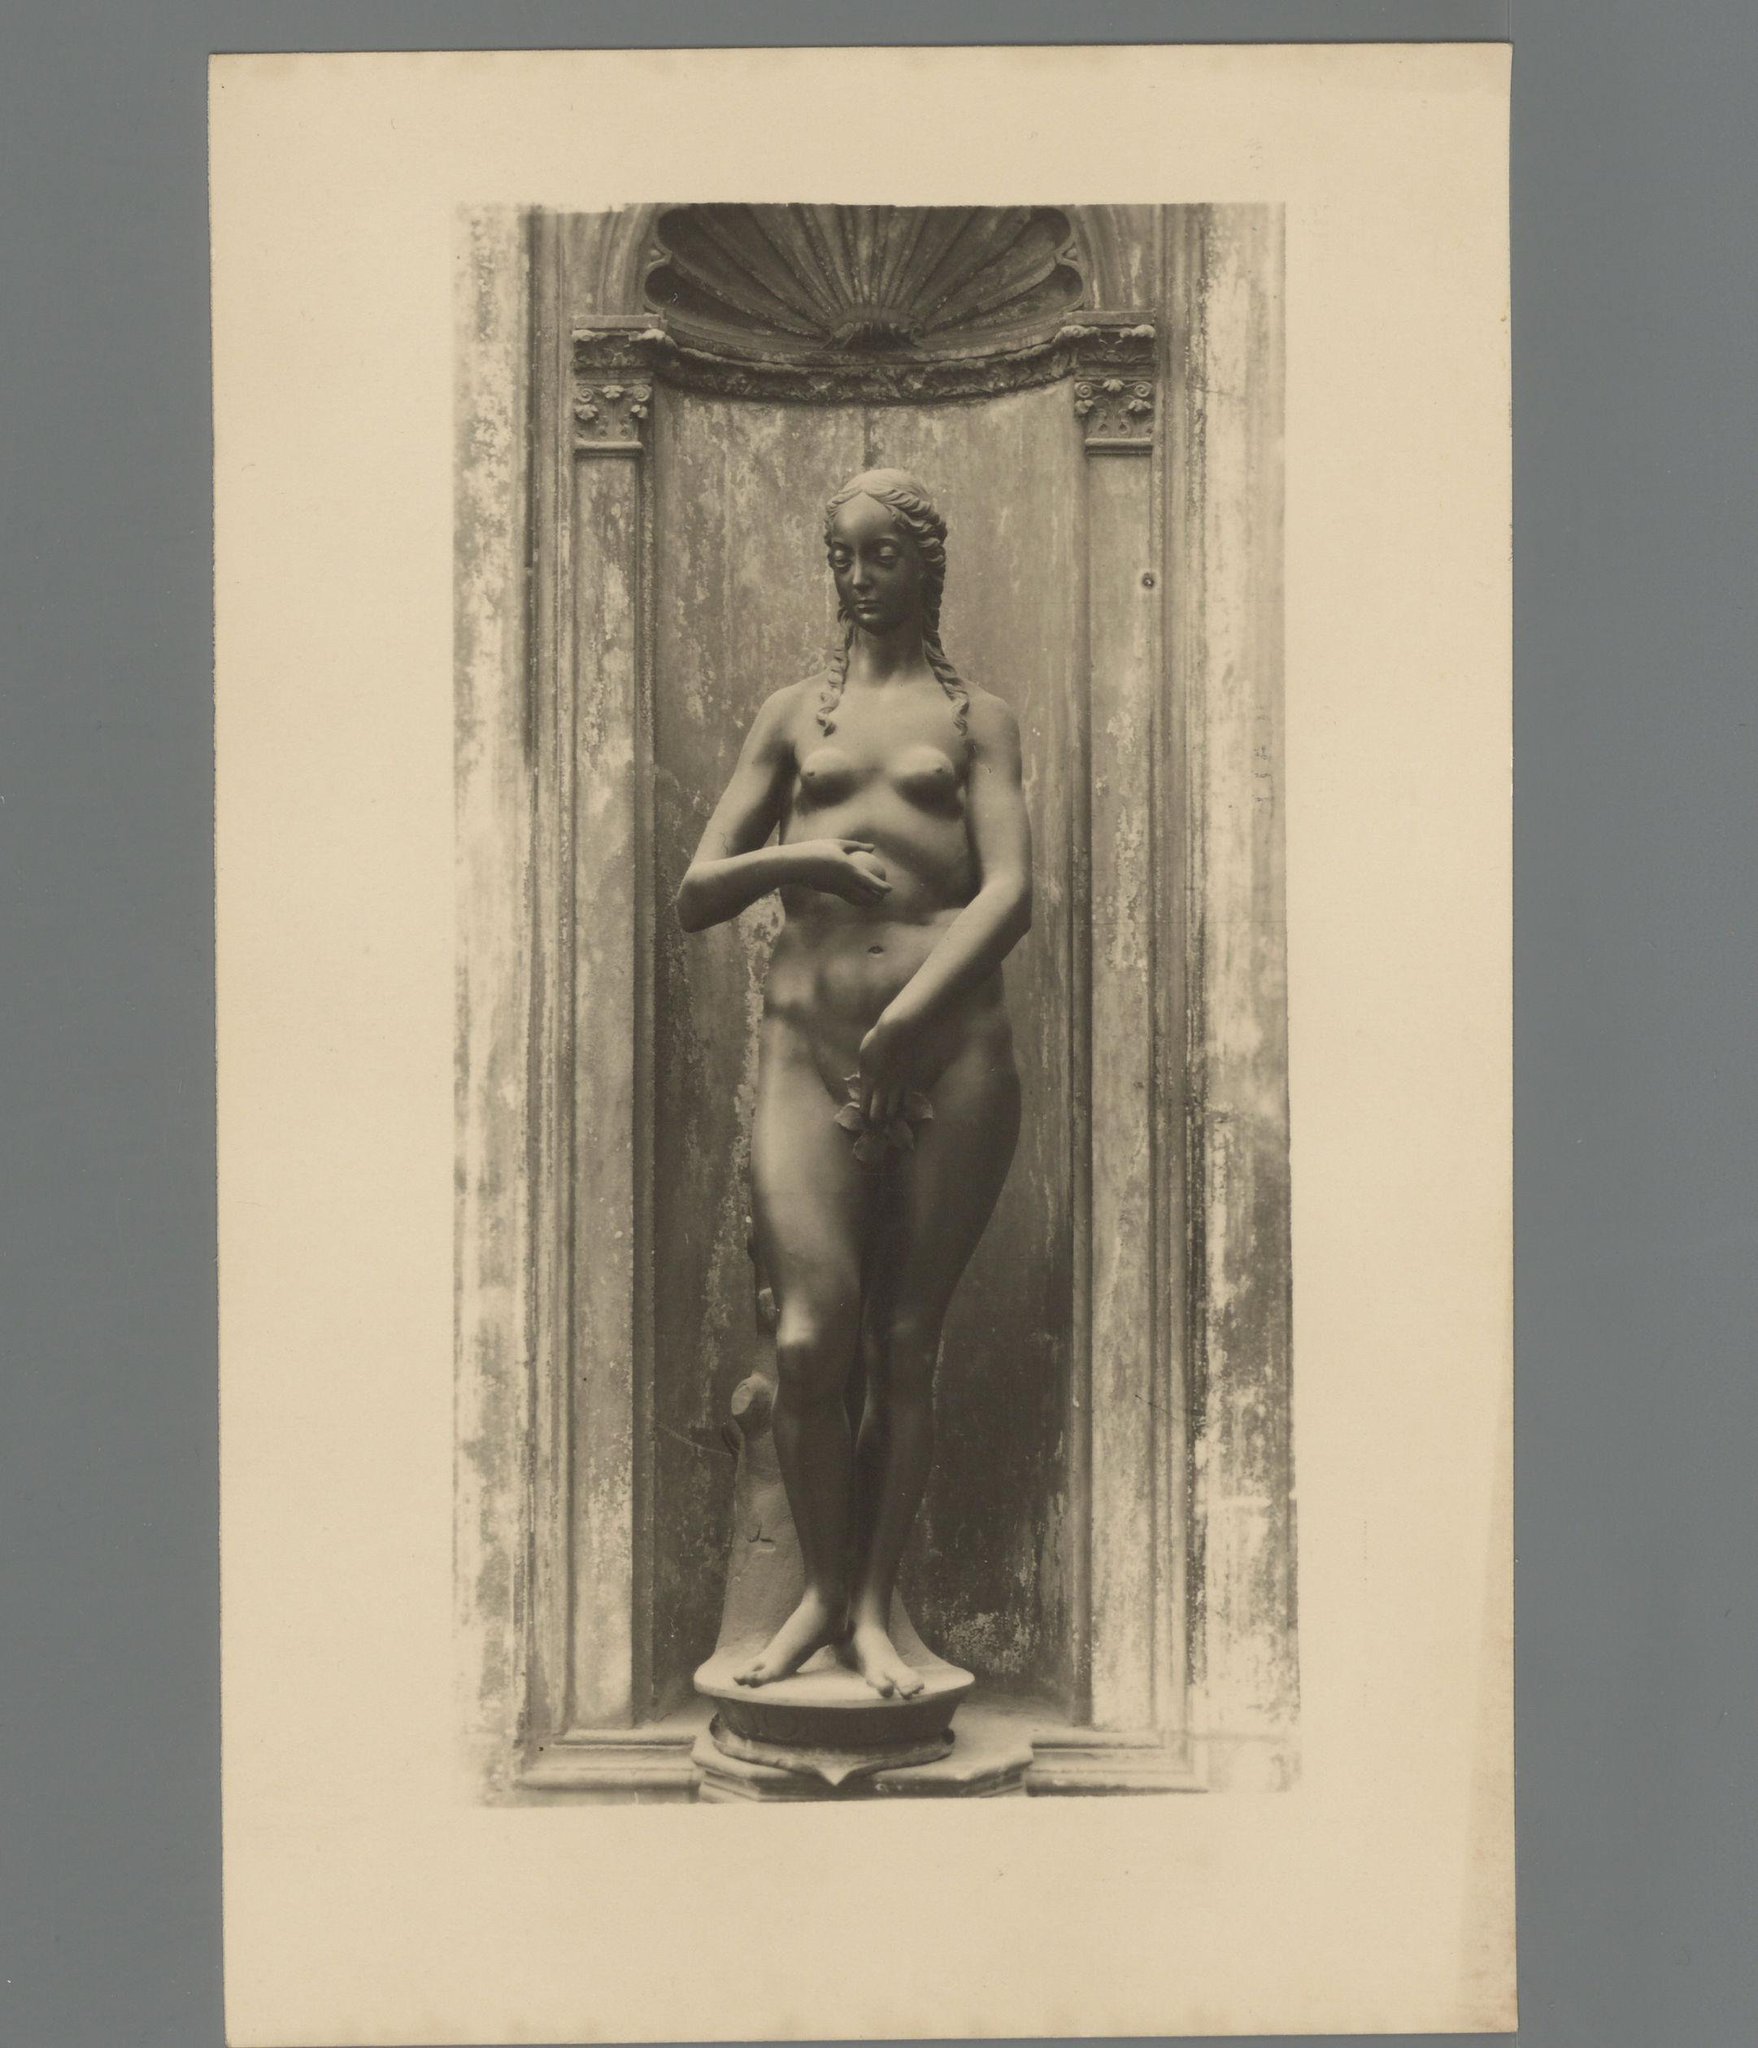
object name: ansichtkaart, prentbriefkaart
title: Venezia - Palazzo Ducale - <Statua di Eva> - A. Rizzo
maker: Anonymous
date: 1906-1930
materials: paper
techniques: gelatin silver print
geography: venice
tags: statues, paintings, etc. ~ objects of worship in roman religion, permanent exhibition, museum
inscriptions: inscription: ‘Fot[...] brocca Venezia’, collector's mark: ‘AFE v S’